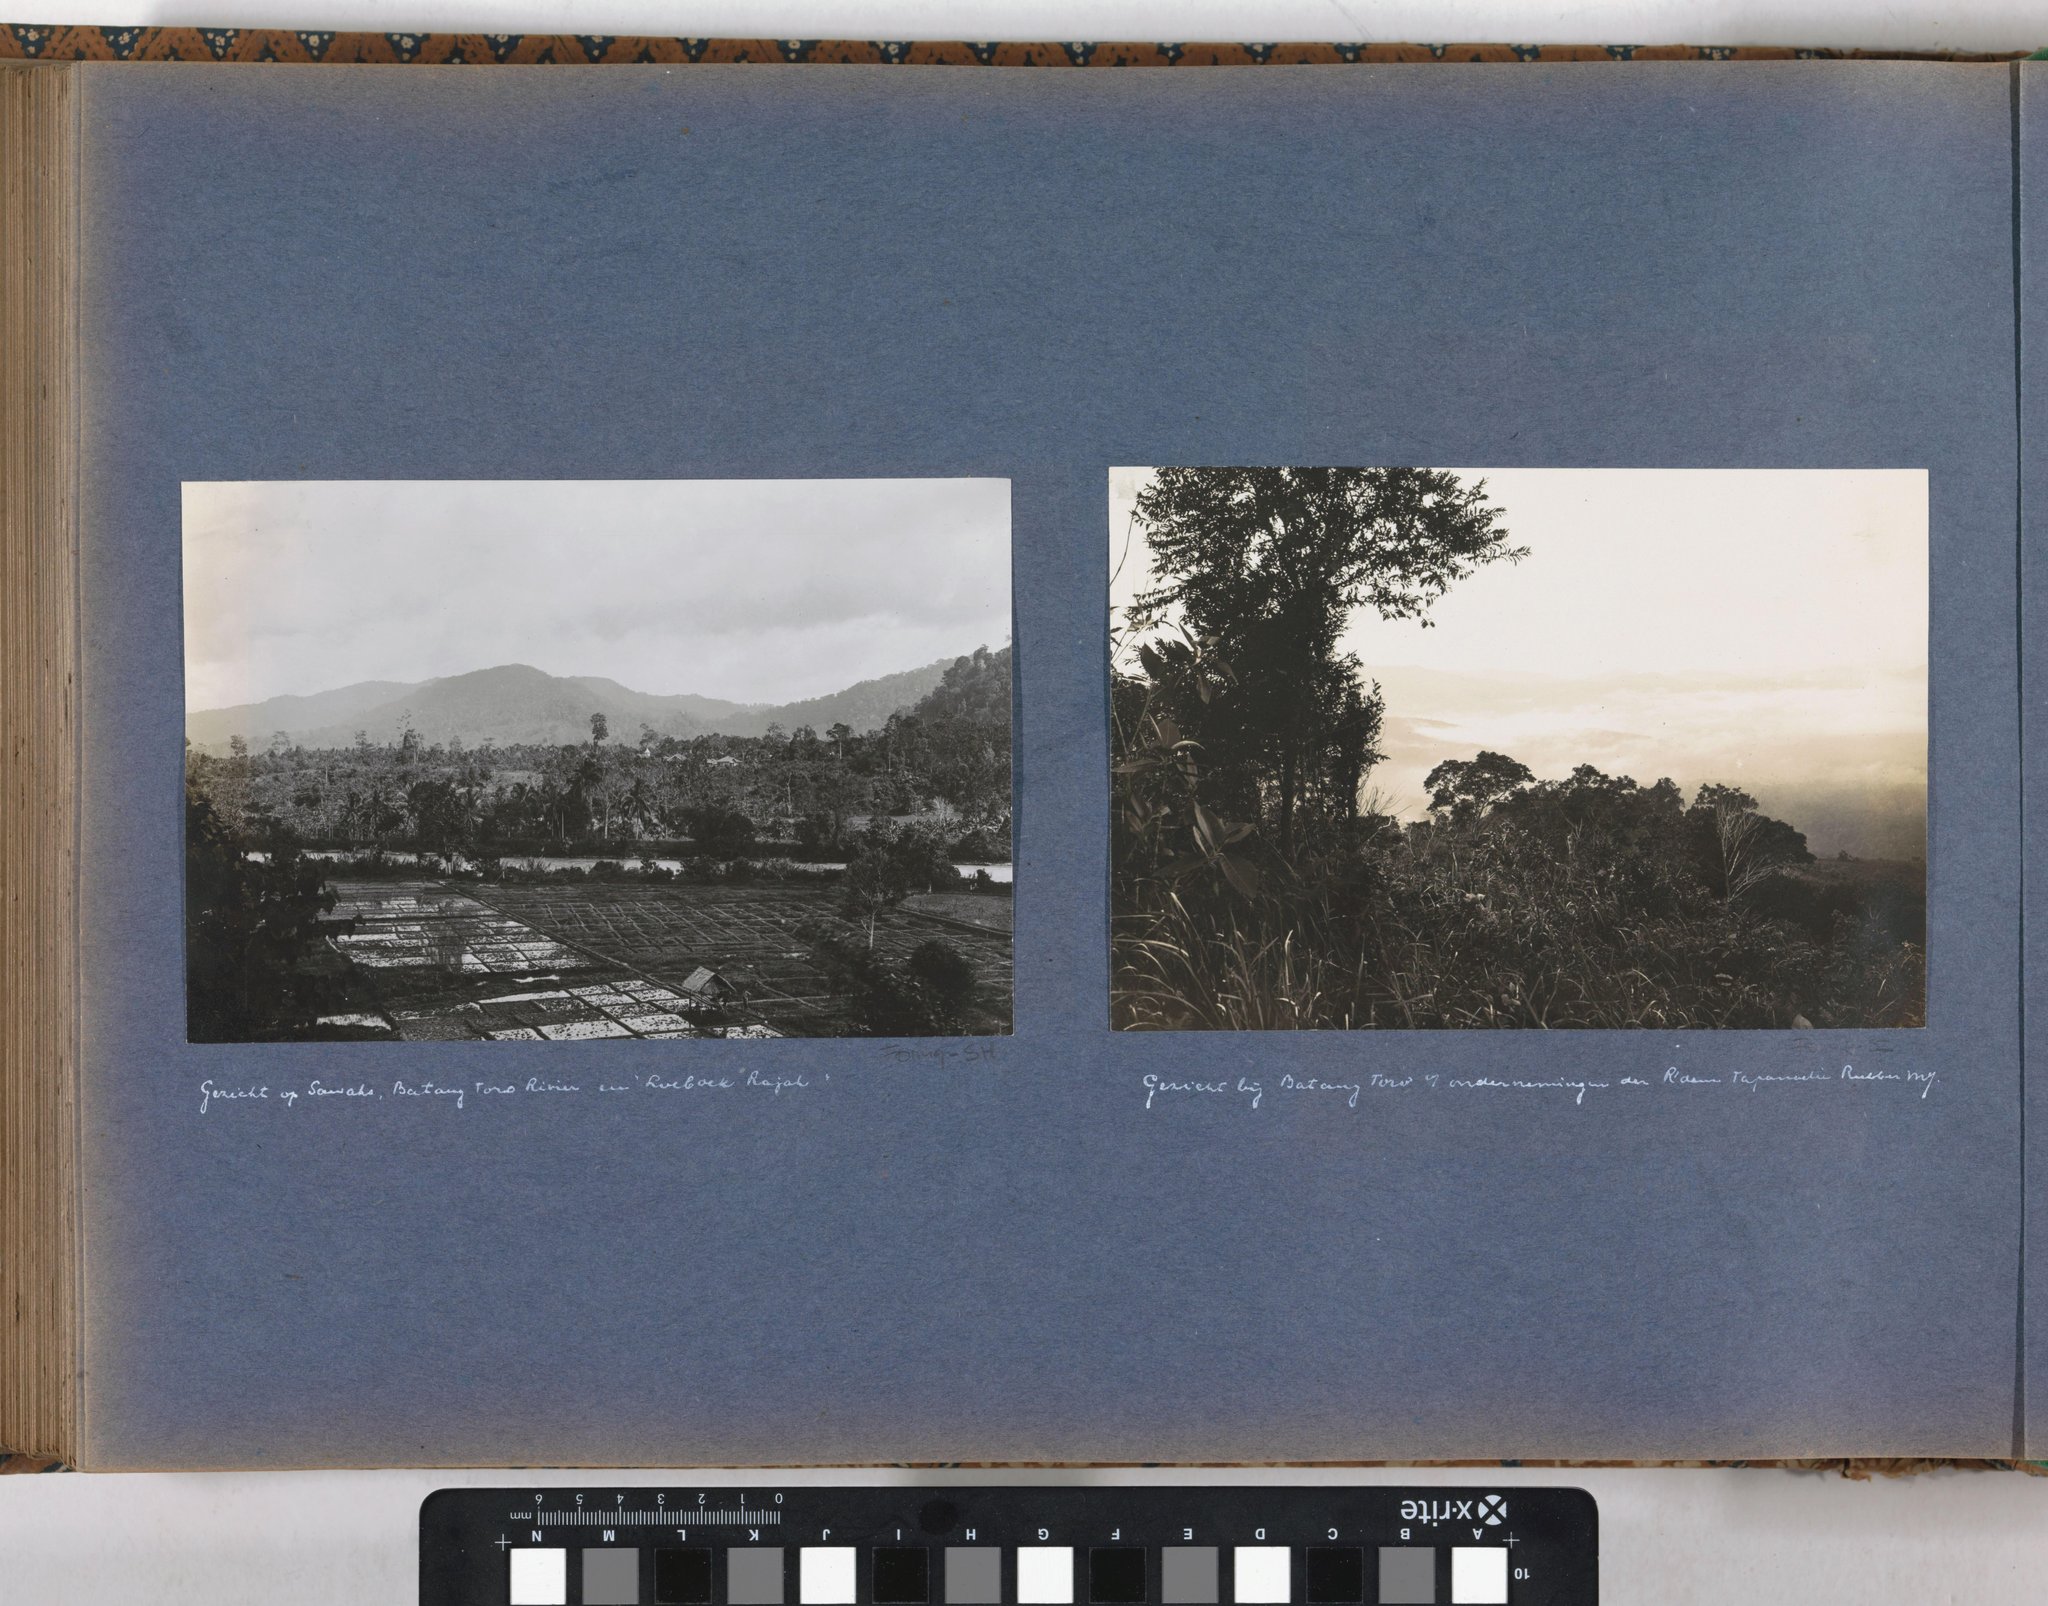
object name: photograph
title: Landschap bij Loeboek Raja op Sumatra met sawa's, de Batang Torurivier en bergen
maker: Anonymous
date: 1900-1920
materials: paper, photographic support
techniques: gelatin silver print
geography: sumatra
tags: field filled with a crop, sawahs, rice paddies, river (+ landscape with figures, staffage), mountains (in tropical and sub-tropical regions), sumatra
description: Onderdeel van reisalbum met foto's van bedrijvigheid en bezienswaardigheden op Sumatra en Java en van de reis naar en van Nederlands-Indië.